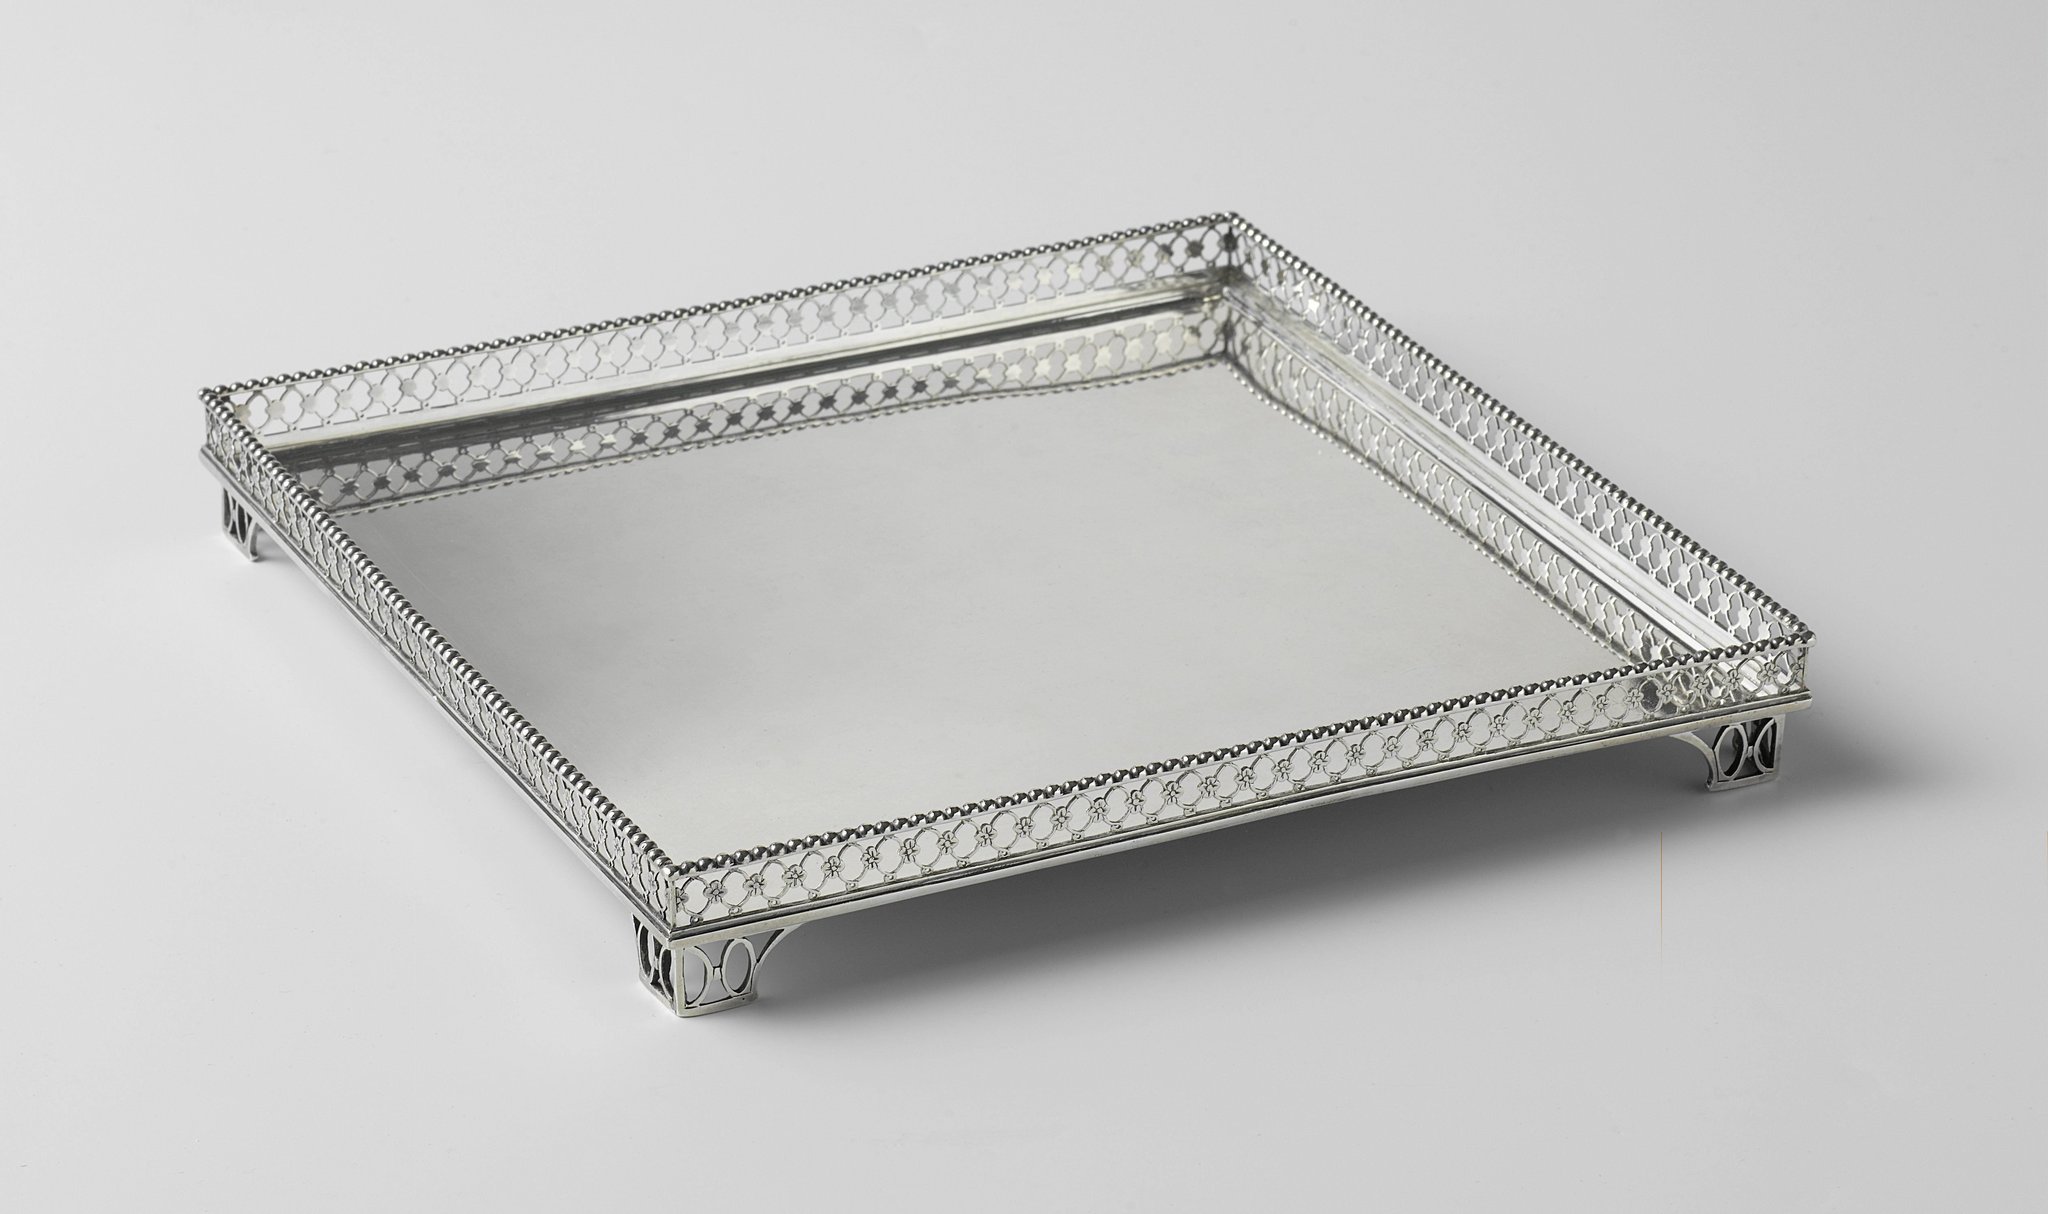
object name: salver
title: Presenteerblad, vierkant, met opstaande opengezaagde rand.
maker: reynier brandt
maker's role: silversmith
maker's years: 1707-1788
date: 1782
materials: silver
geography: amsterdam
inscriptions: date letter: ‘X’, town mark, : ‘ZII’, alloy mark, maker's mark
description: Het vierkante blad heeft een verhoogde vlakke rand. De opstaande wand is opengezaagd met door rozetten verbonden guilloches, die aan de buitenzijde gegraveerd zijn. Hij wordt aan de onderzijde afgesloten door een getrapte profiellijst en aan de bovenzijde door een parelrand. Het blad rust op vier iets inspringende pootjes. De rechte wanden daarvan hebben een gebogen binnenzijde en zijn opengezaagd met ovalen. (Catalogus Amsterdams Goud en Zilver, catalogusnummer 120)